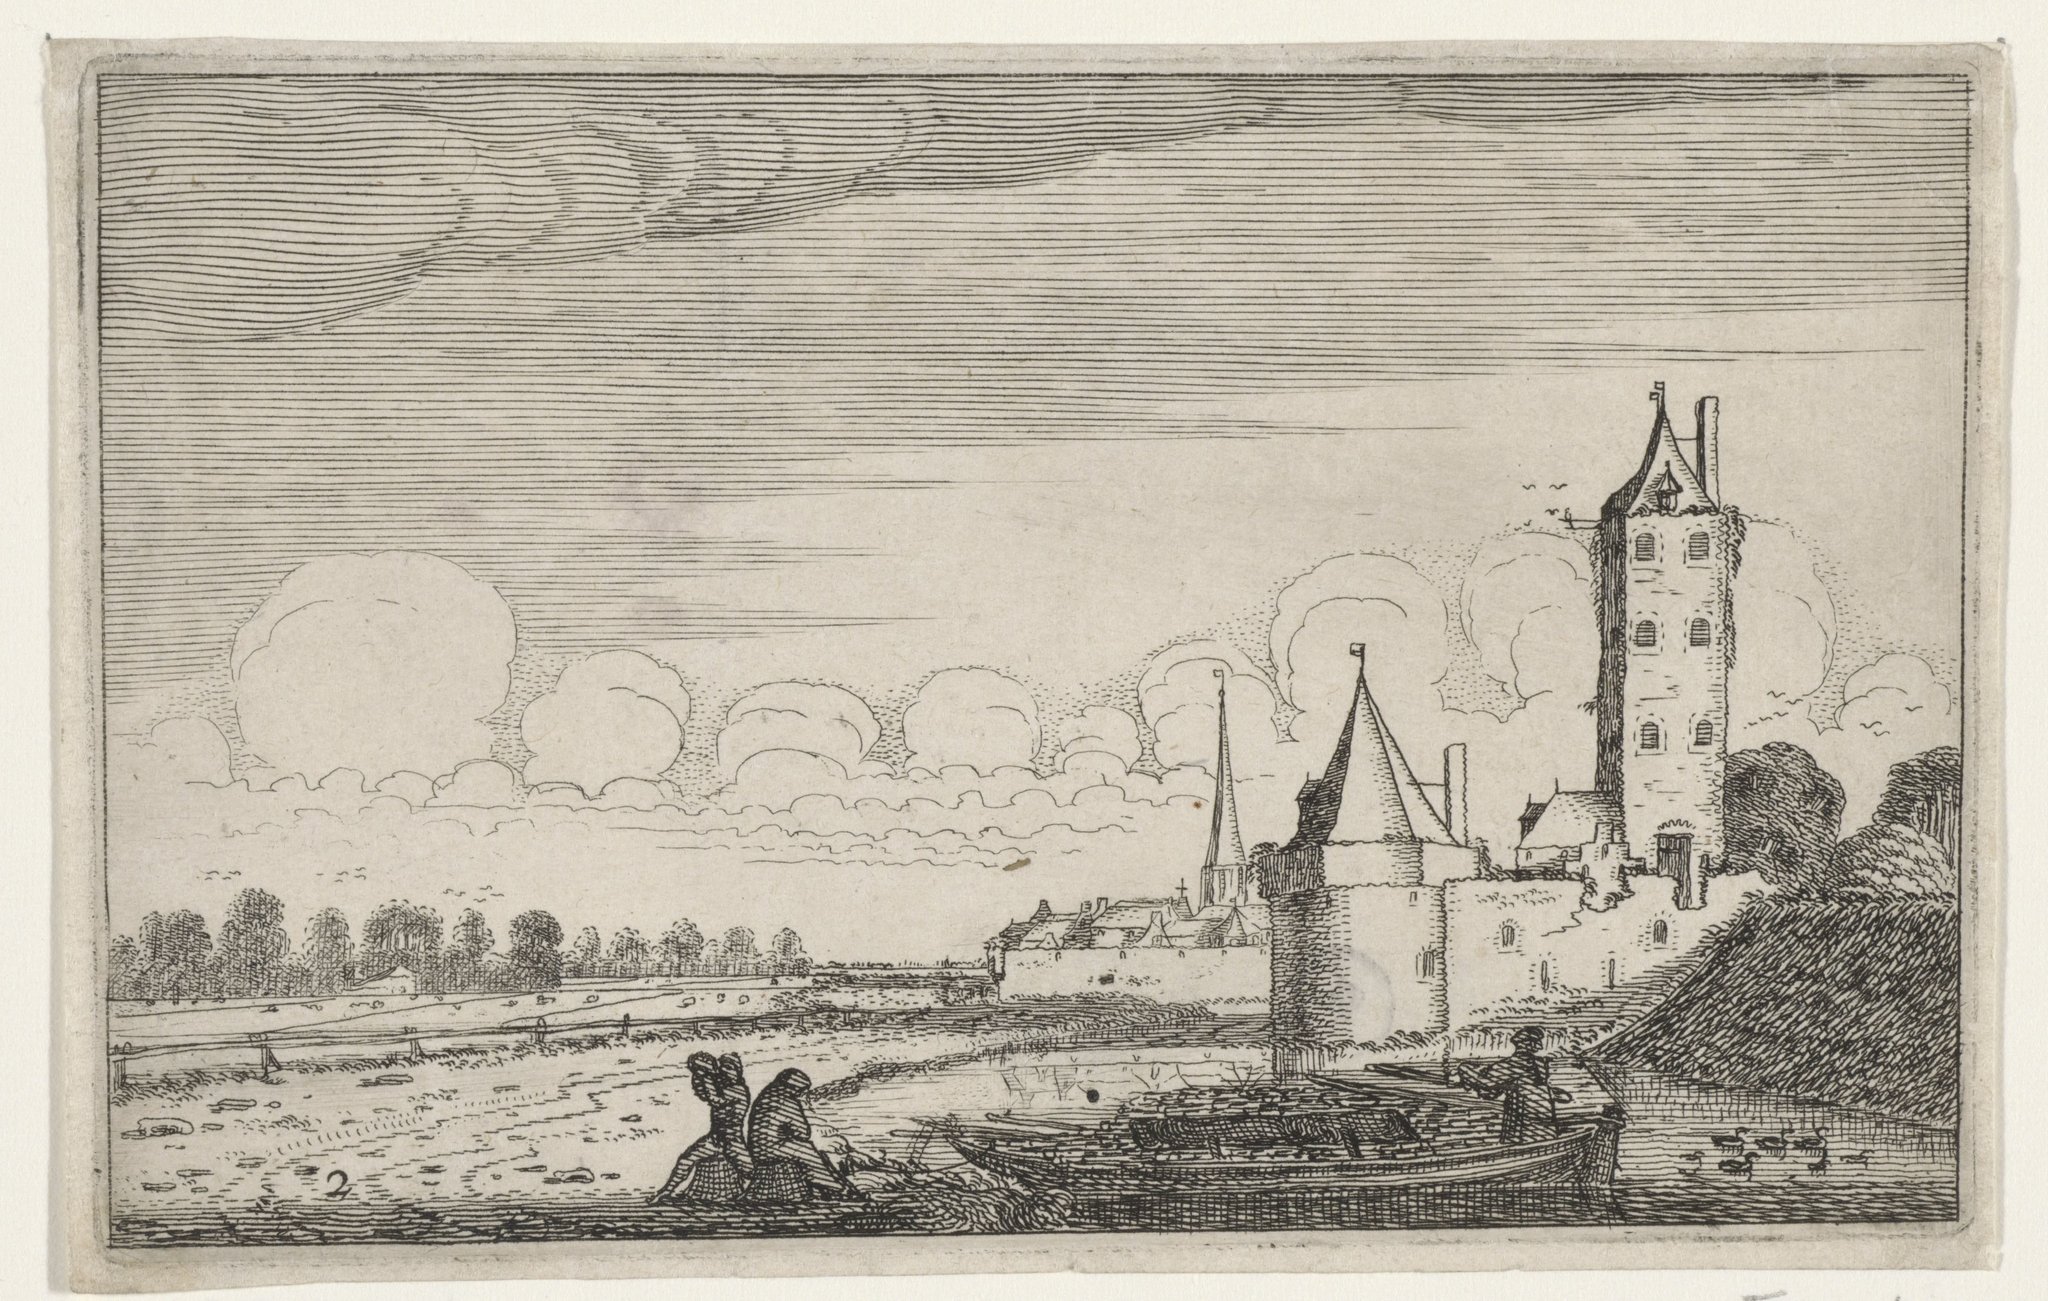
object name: print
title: Regiunculae quoddam amenae ruin aeque anti quidres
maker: jan van de velde (ii)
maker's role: draughtsman, painter, print maker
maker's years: 1593-1641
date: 1616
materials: paper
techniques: engraving, etching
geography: northern netherlands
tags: landscape with ruins, landscape with tower or castle, ruin of a dwelling, house, castle, etc.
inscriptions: collector's mark: Lugt 964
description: Figuren bij een boot in een sloot bij een kasteel in een landschap. Op de achtergrond een dorp. Tweede prent uit een serie van twintig.